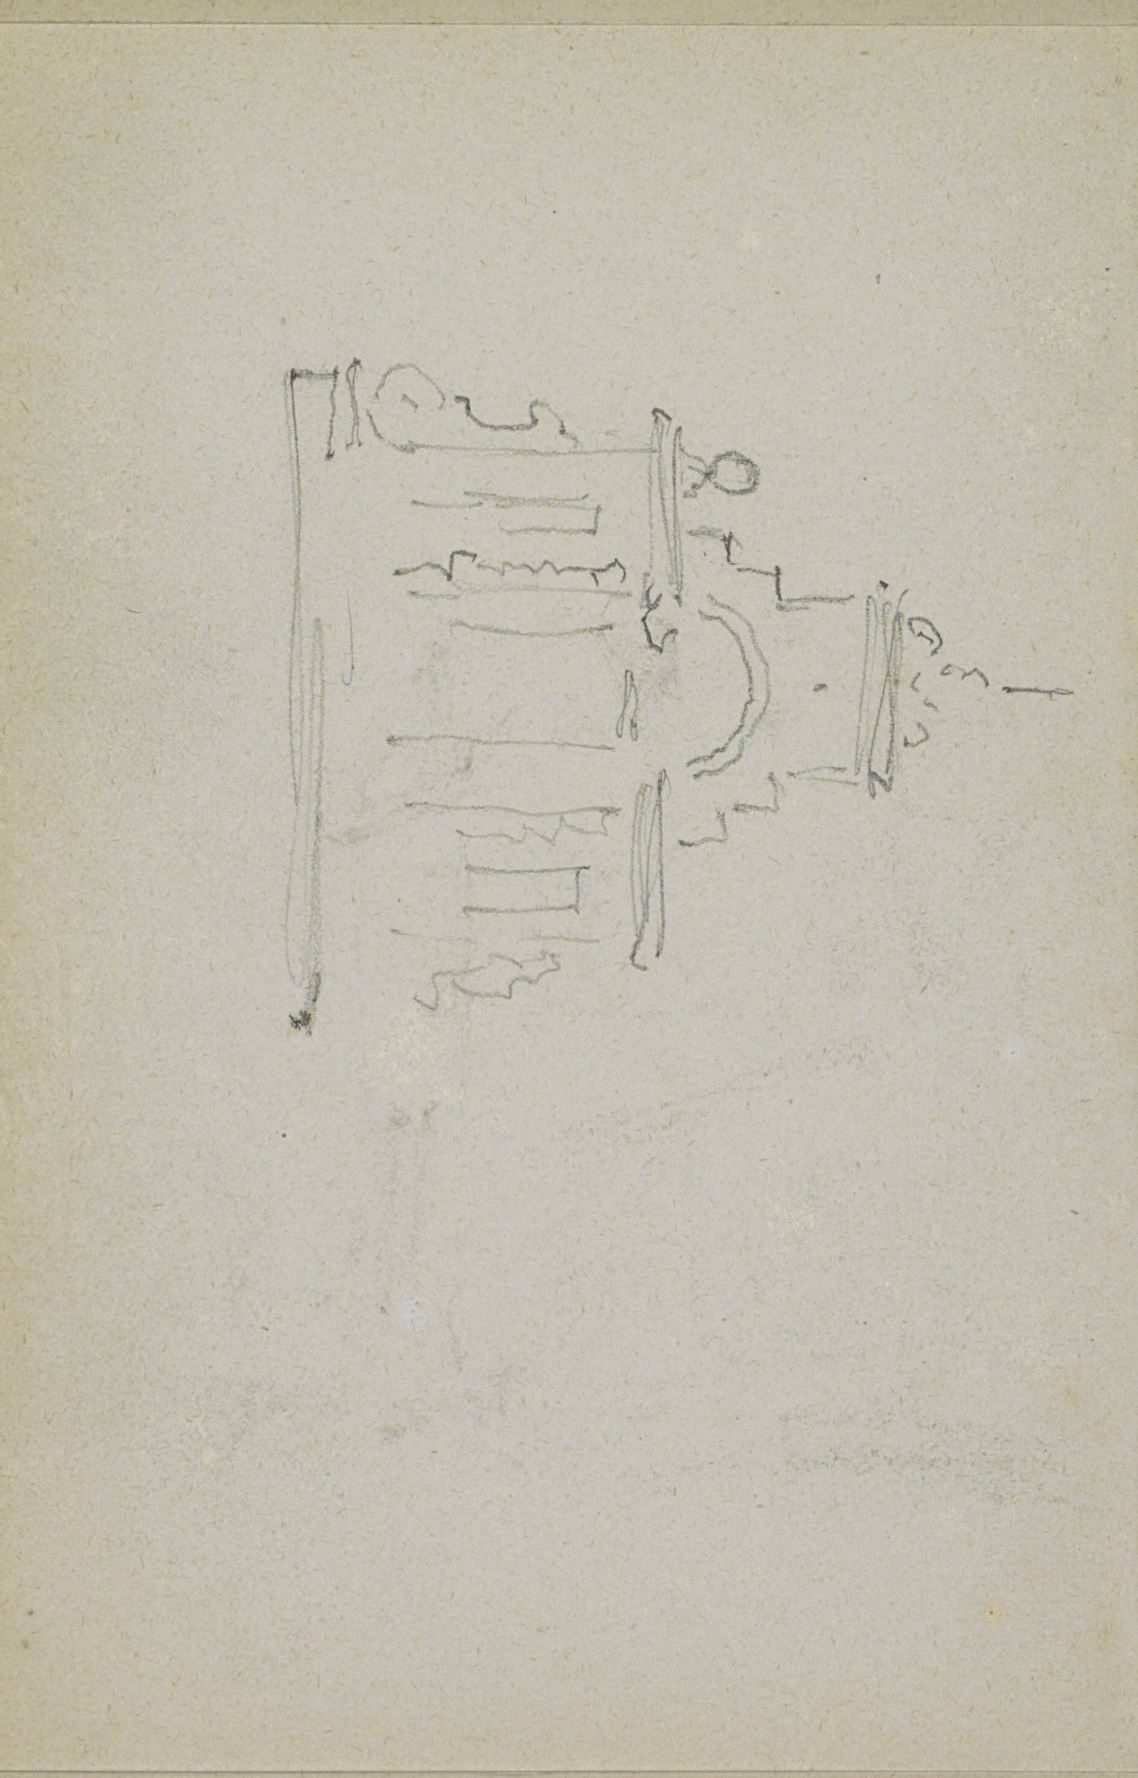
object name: sketchbook leaf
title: Topgevel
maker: adrianus eversen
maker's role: draughtsman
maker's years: 1818-1897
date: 1828-1897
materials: paper, pencil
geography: netherlands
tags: decorated gable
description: Topgevel met voluten. Blad 6 verso uit een schetsboek met 58 bladen.